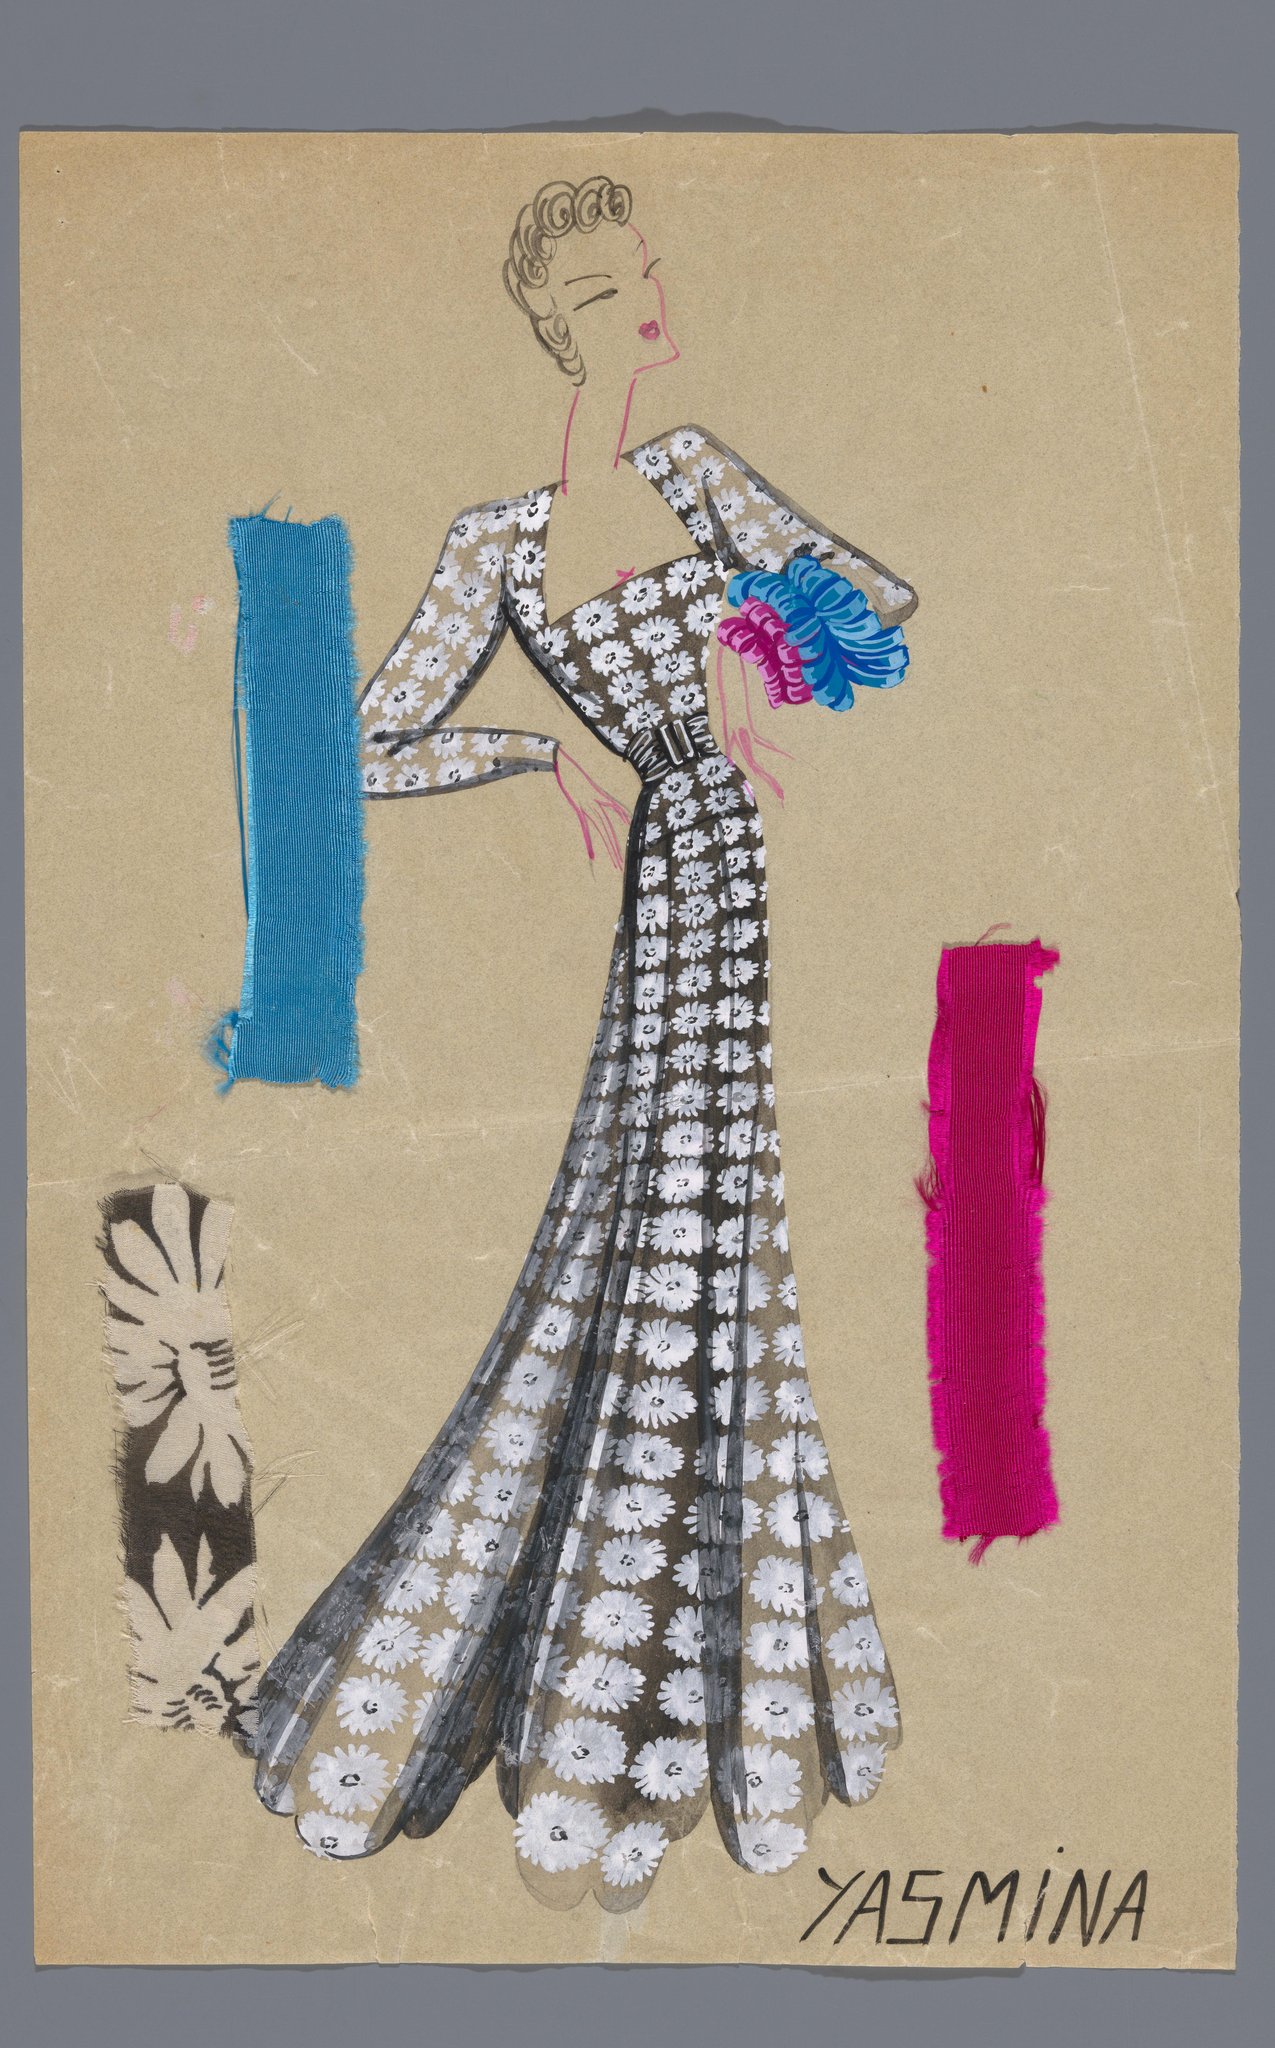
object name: fashion plate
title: Yasmina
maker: jeanne lanvin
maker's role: couturier, modeontwerper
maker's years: 1867-1946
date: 1939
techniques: brush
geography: paris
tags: fashion plates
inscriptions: title: ‘Yasmina’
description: Lange japon in zwarte mousseline met witte bloemen. Armbanden in blauwe en rode stof. Van deze stof zijn twee staaltjes op het papier bevestigd. Linksonder een staaltje van de stof van de japon.